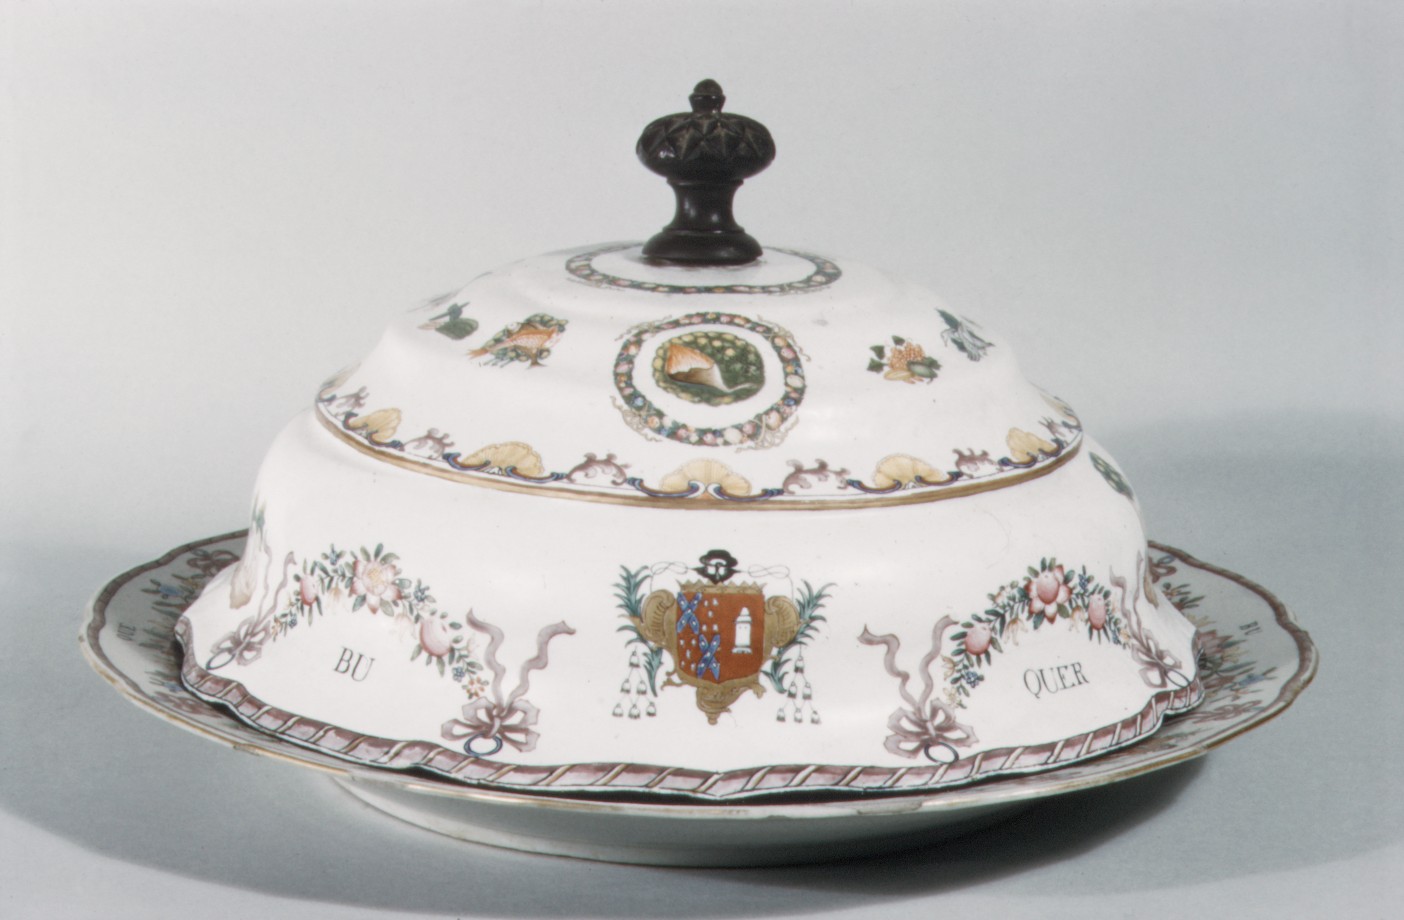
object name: cover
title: Cover (part of a service)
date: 1765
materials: copper, enamel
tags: coat of arms